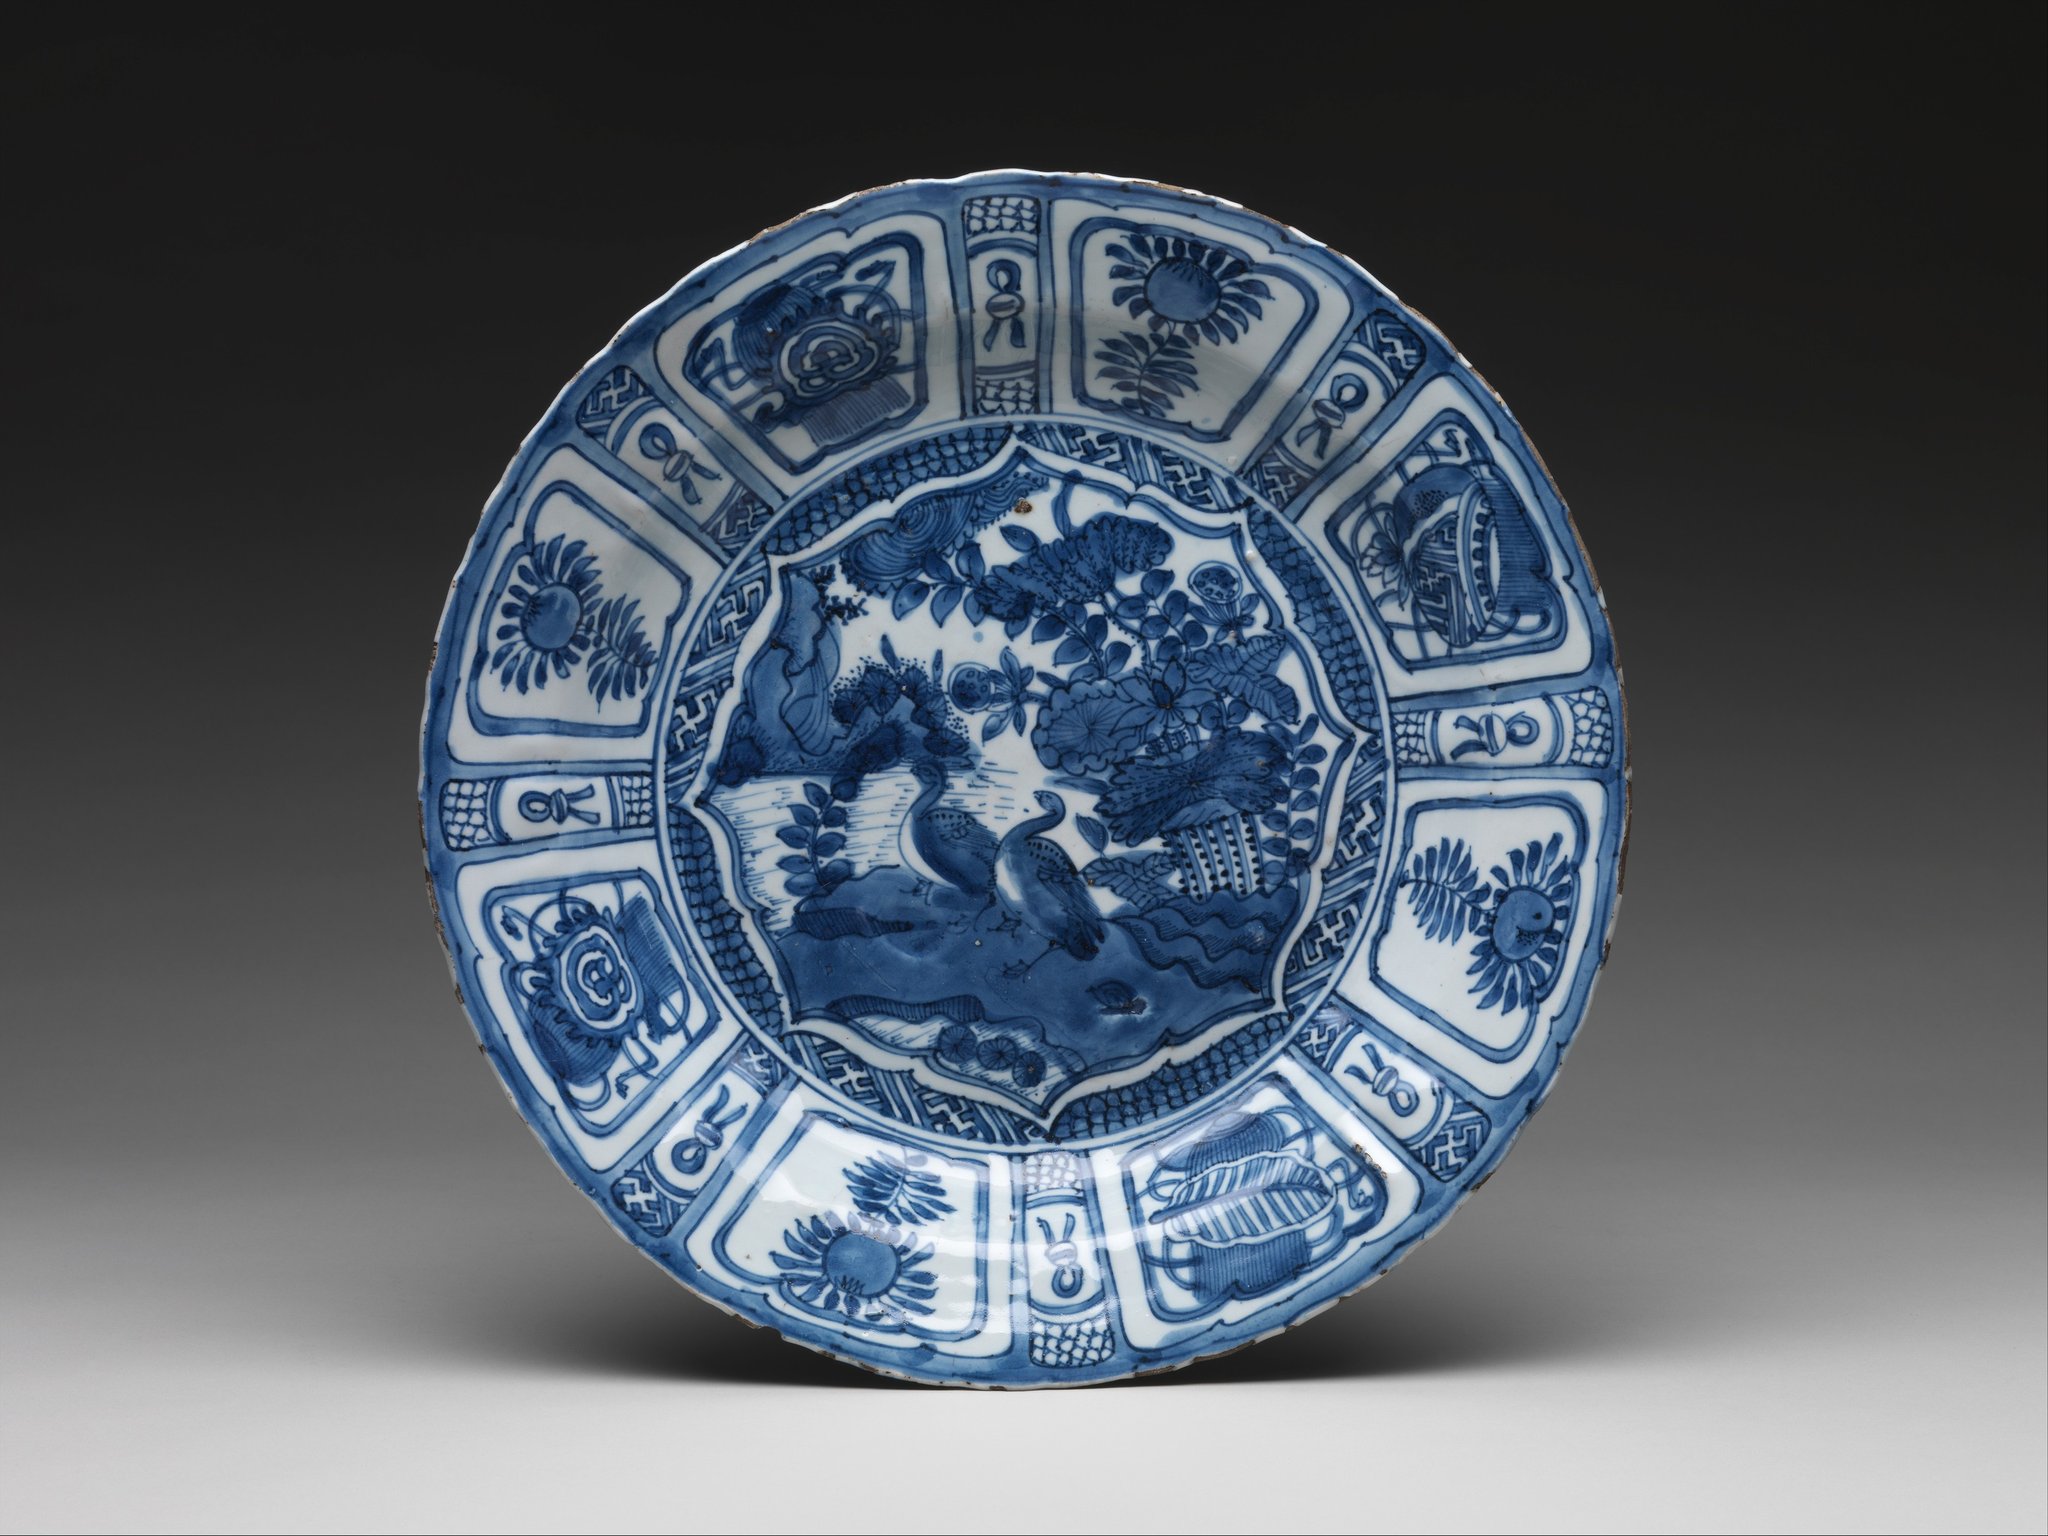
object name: plate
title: Plate with Geese in a Lotus Pond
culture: chinese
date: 1567-1633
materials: cobalt, glaze, porcelain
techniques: painting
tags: geese